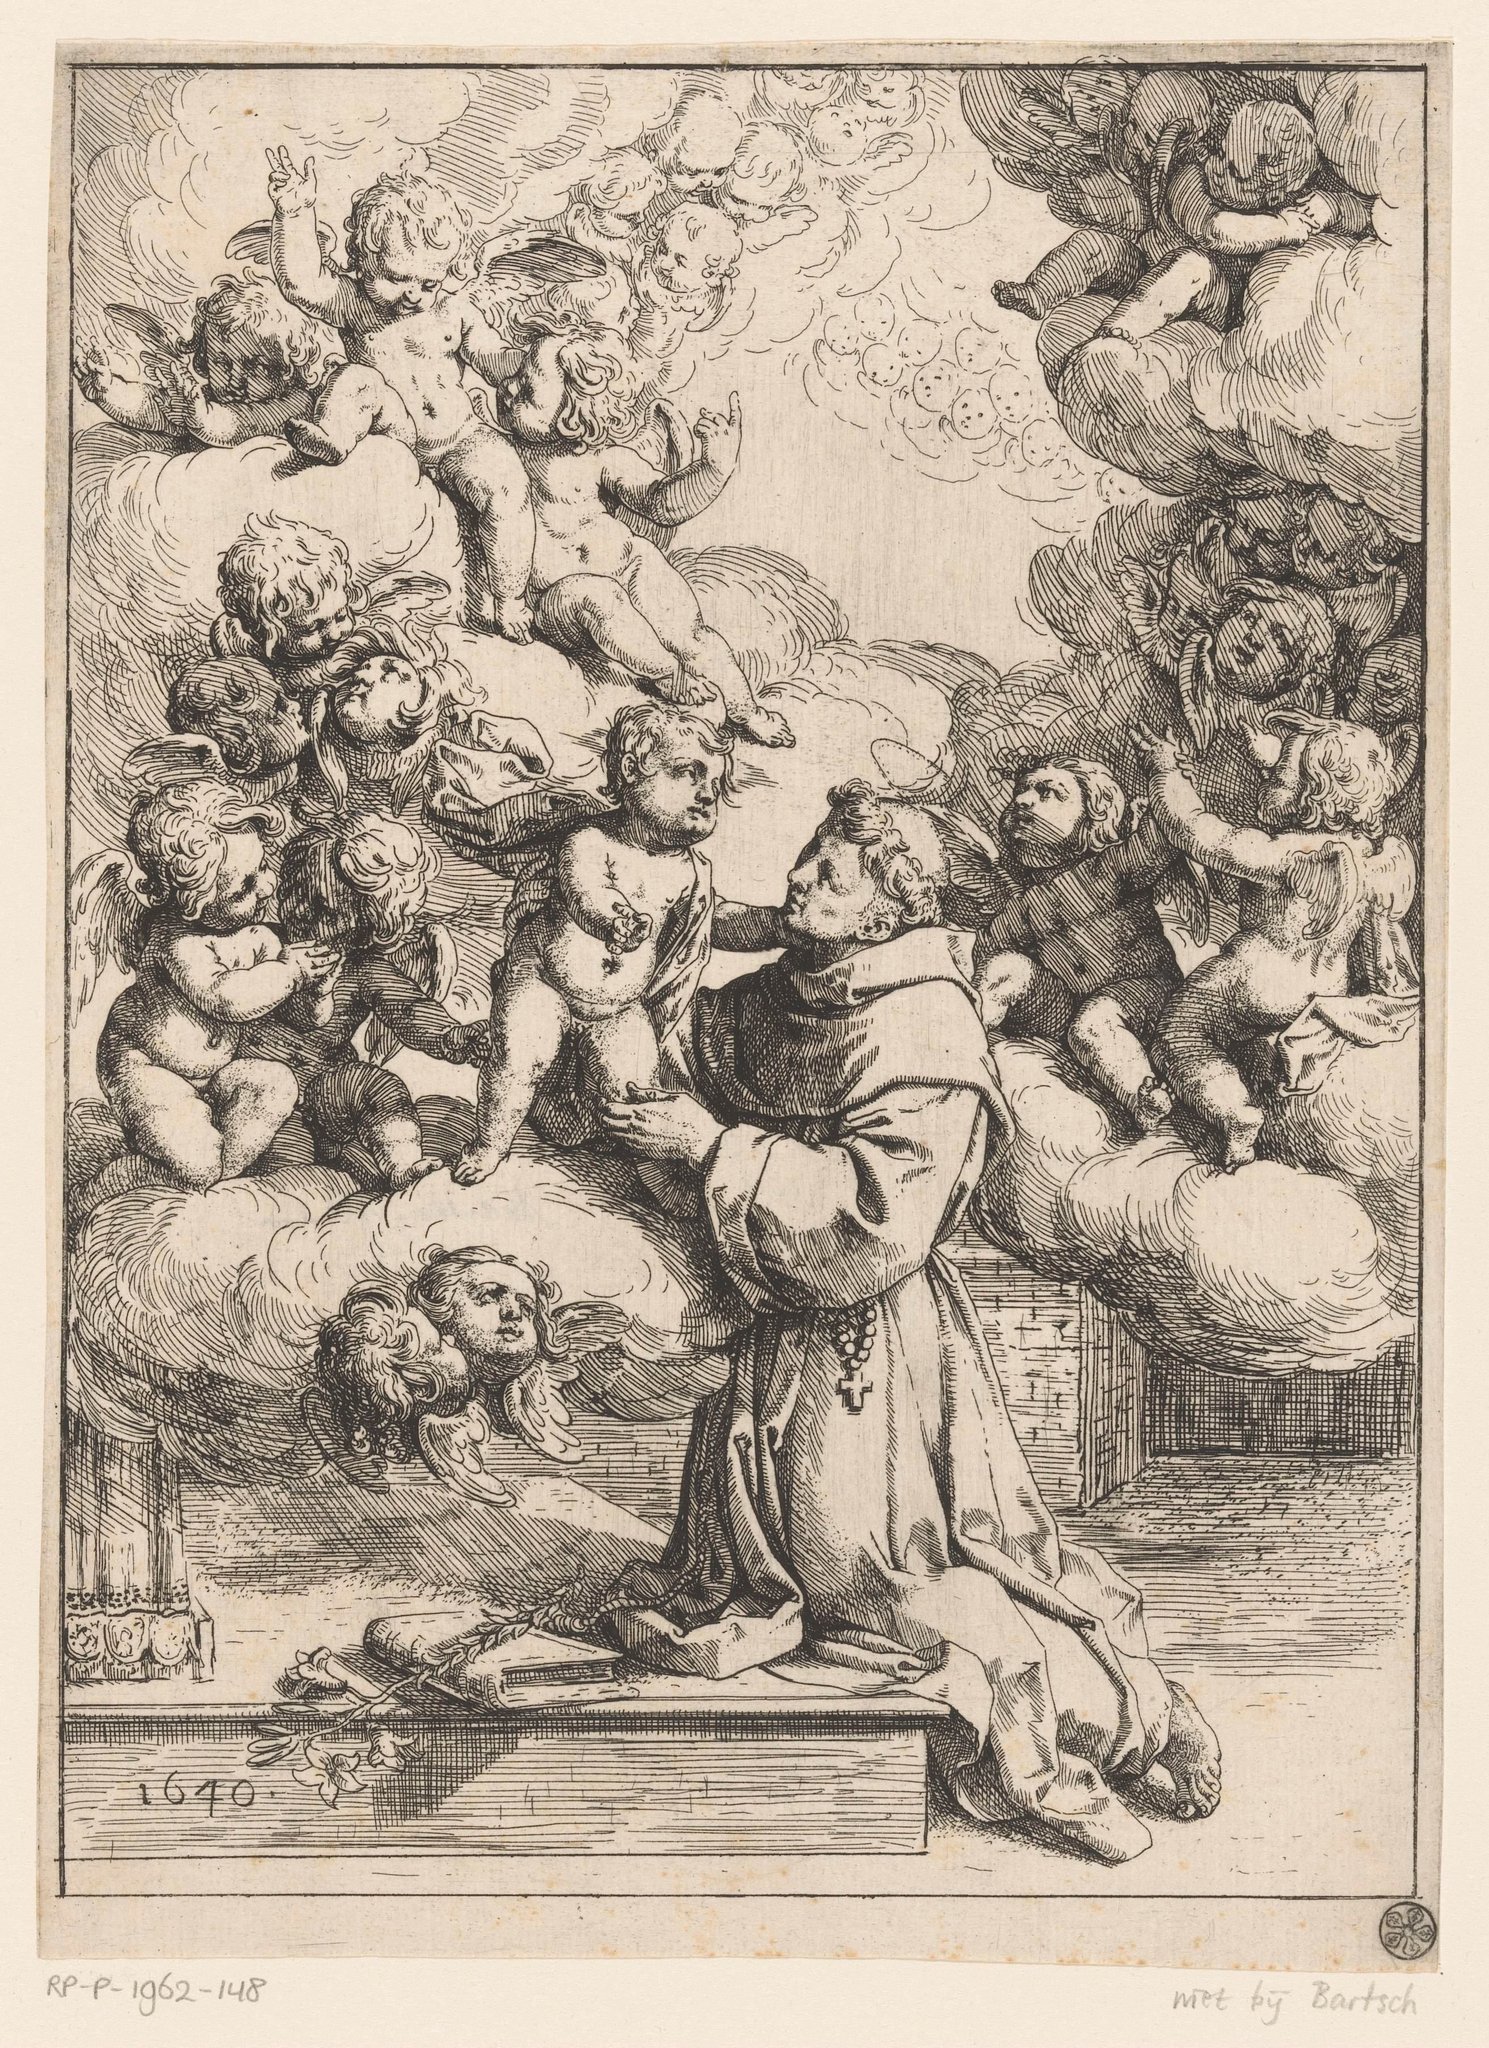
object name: print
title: De heilige Antonius van Padua met het Christuskind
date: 1640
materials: paper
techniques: etching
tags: cherubs, i.e. children's heads with wings, the infant christ appears to st. antony of padua; he embraces or worships the child, the franciscan monk antony of padua; possible attributes: ass, book, crucifix, flowered cross, flaming heart, infant christ (on book), lily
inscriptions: collector's mark: Lugt 2228, collector's mark: Lugt 2775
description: De heilige Antonius van Padua knielt in aanbidding voor het Christuskind. Rondom Christus zweven putti en cherubijnen op wolken.